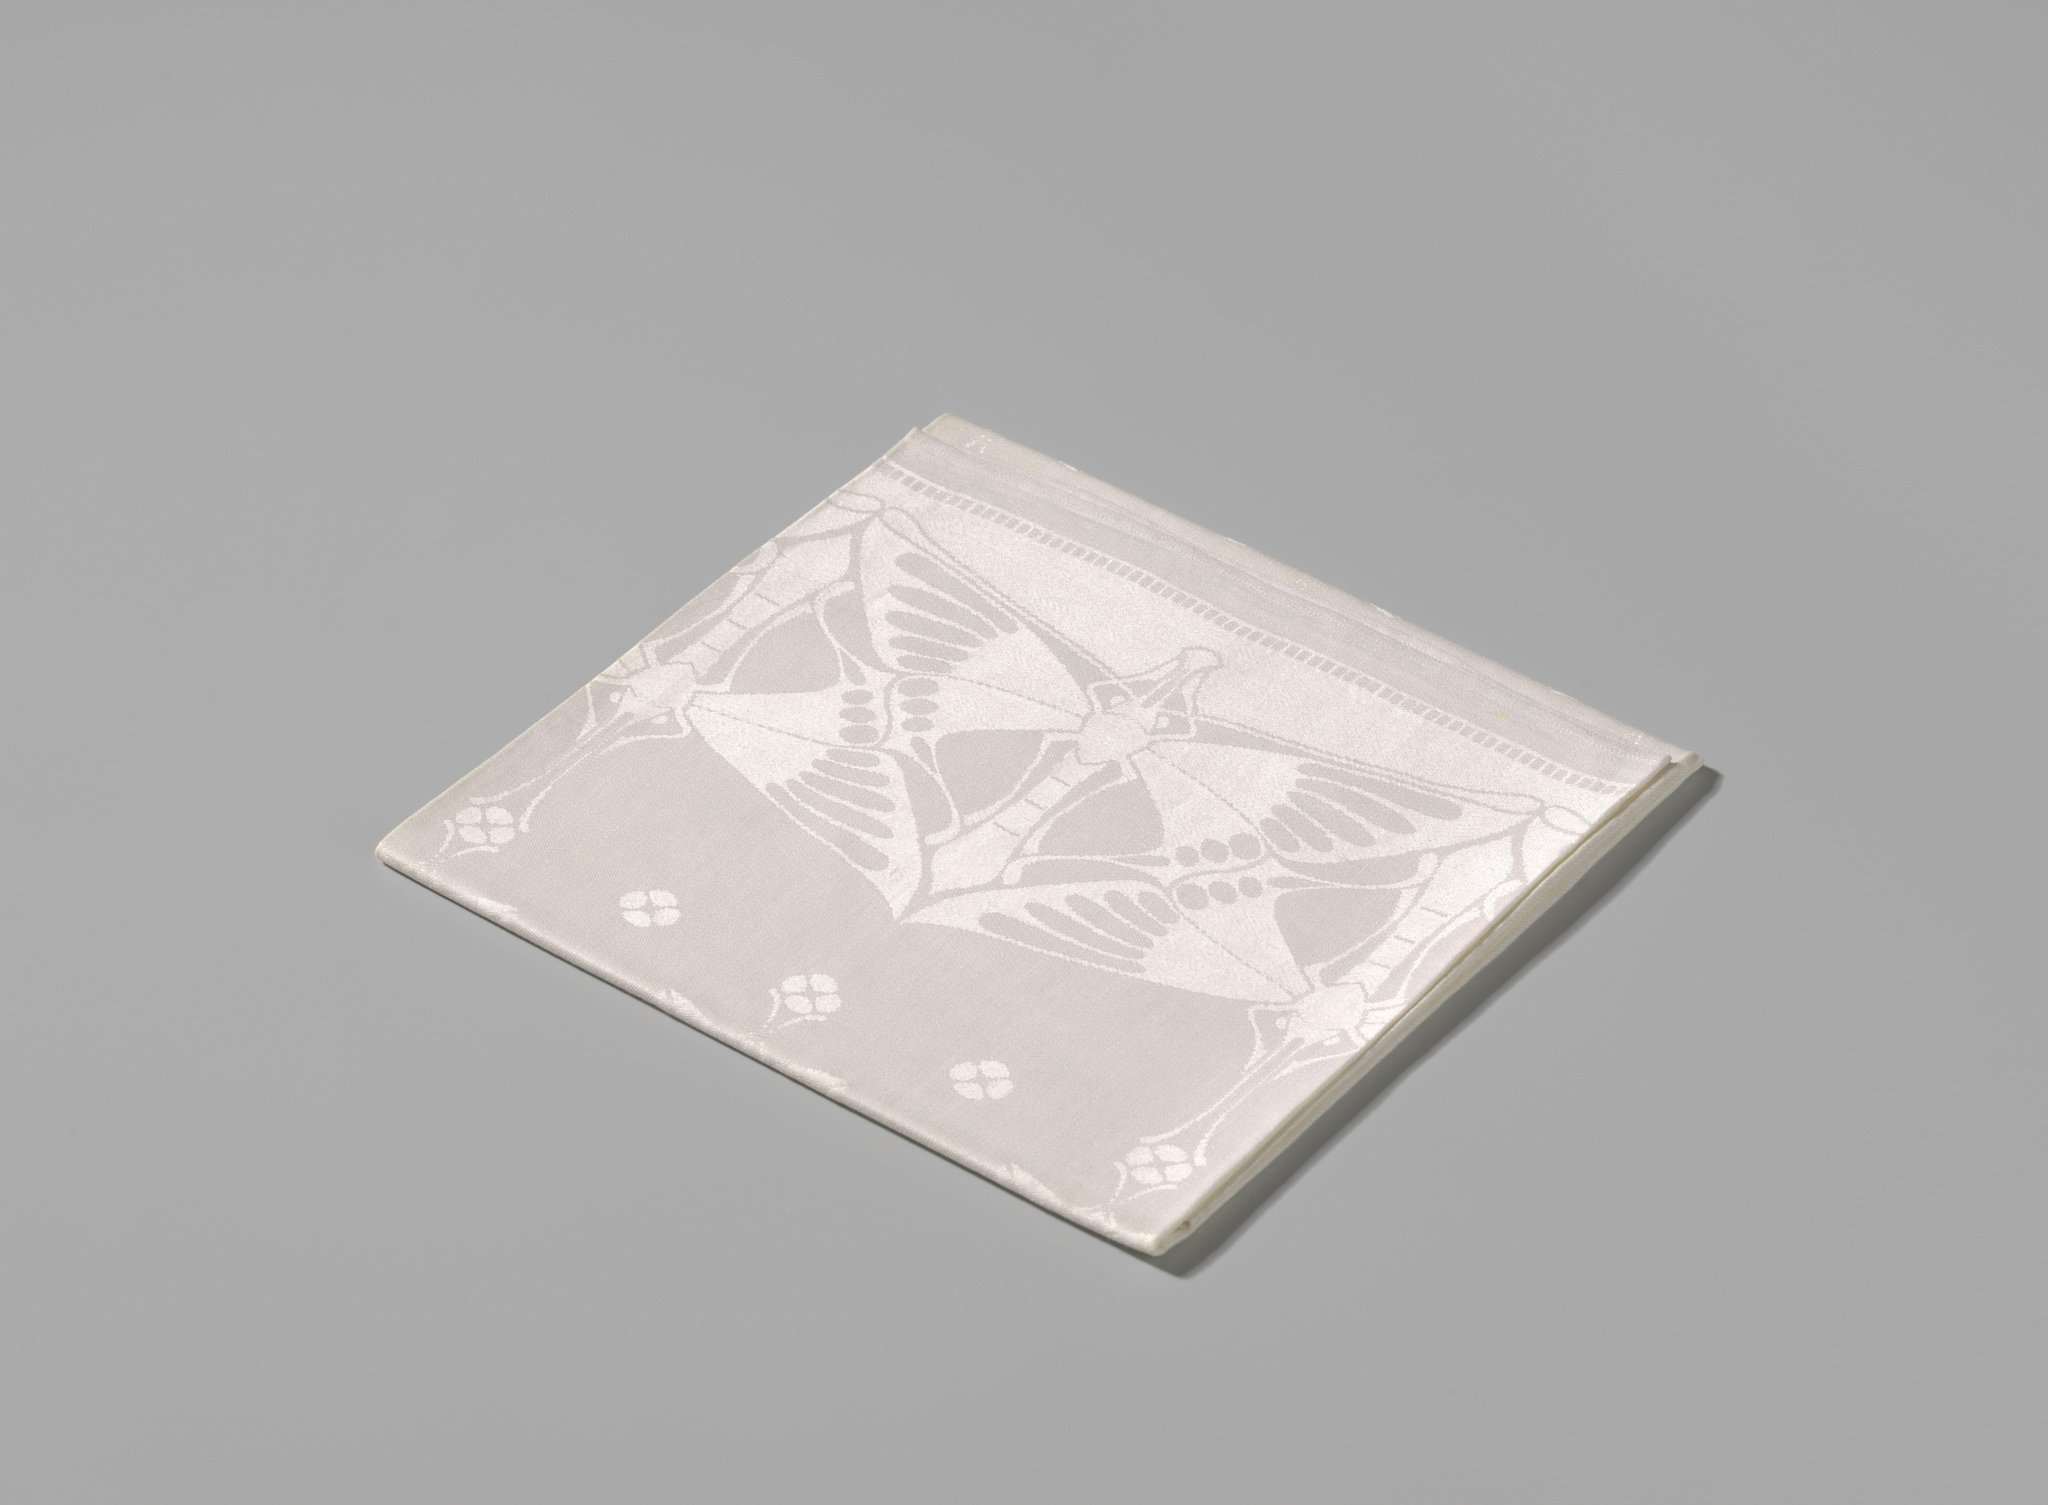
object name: napkin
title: Servet van linnendamast met vlinders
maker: chris lebeau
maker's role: draughtsman, print maker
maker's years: 1878-1945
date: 1904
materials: linen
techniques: damask, weave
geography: eindhoven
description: Servet van linnendamast met vlinders: motief Vlinder, dessin nr. 505. Het servet hoort bij twaalf servetten (BK-1979-259-A t/m BK-1979-259-M), twaalf vingerdoeken (BK-1979-260-A t/m BK-1979-260-L) en twee tafellakens (BK-1979-258-A en BK-1979-258-B).